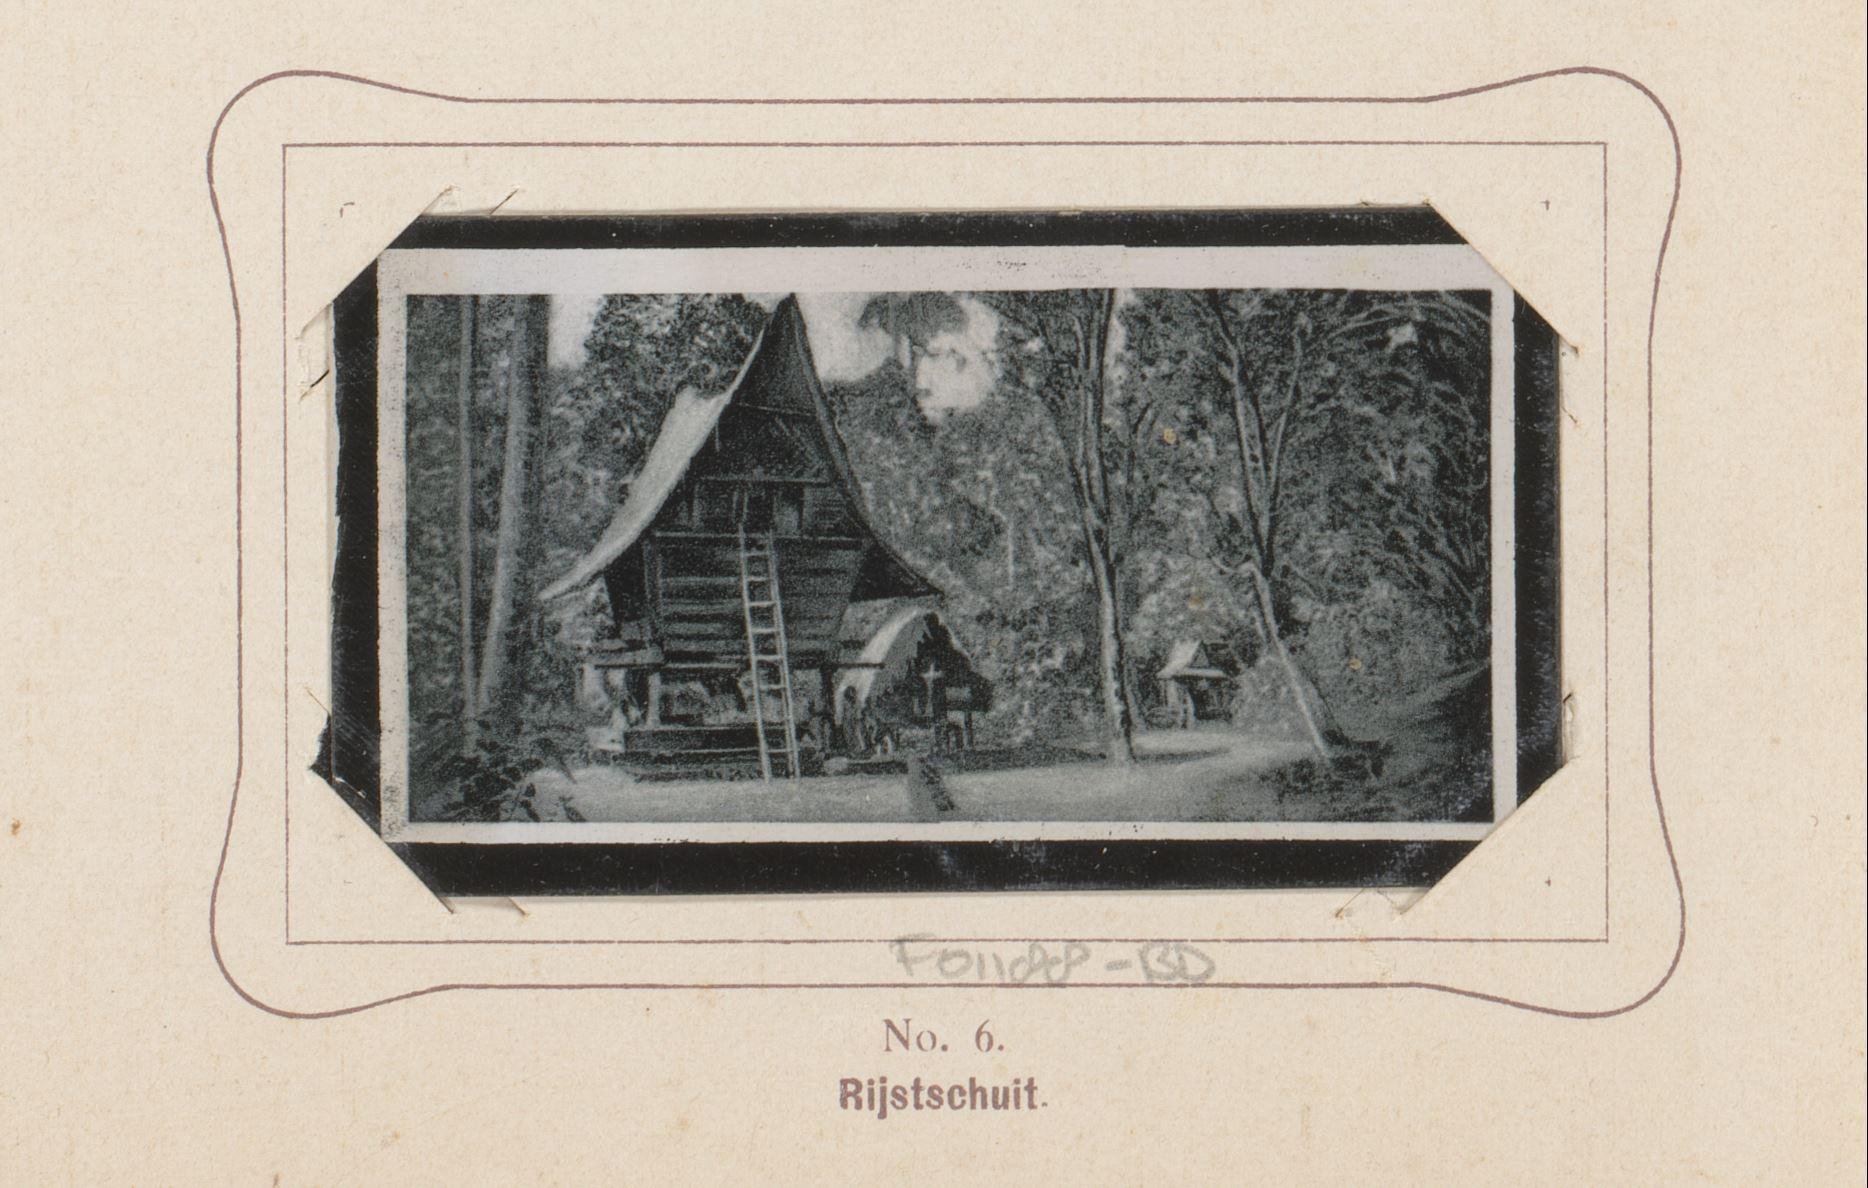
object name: photomechanical print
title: Gezicht op een rijstschuur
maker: Anonymous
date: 1906-1907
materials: paper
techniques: photograph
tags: barn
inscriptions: inscription: ‘No. 6./ Rijstschuit.’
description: Deze prent maakt deel uit van een album.